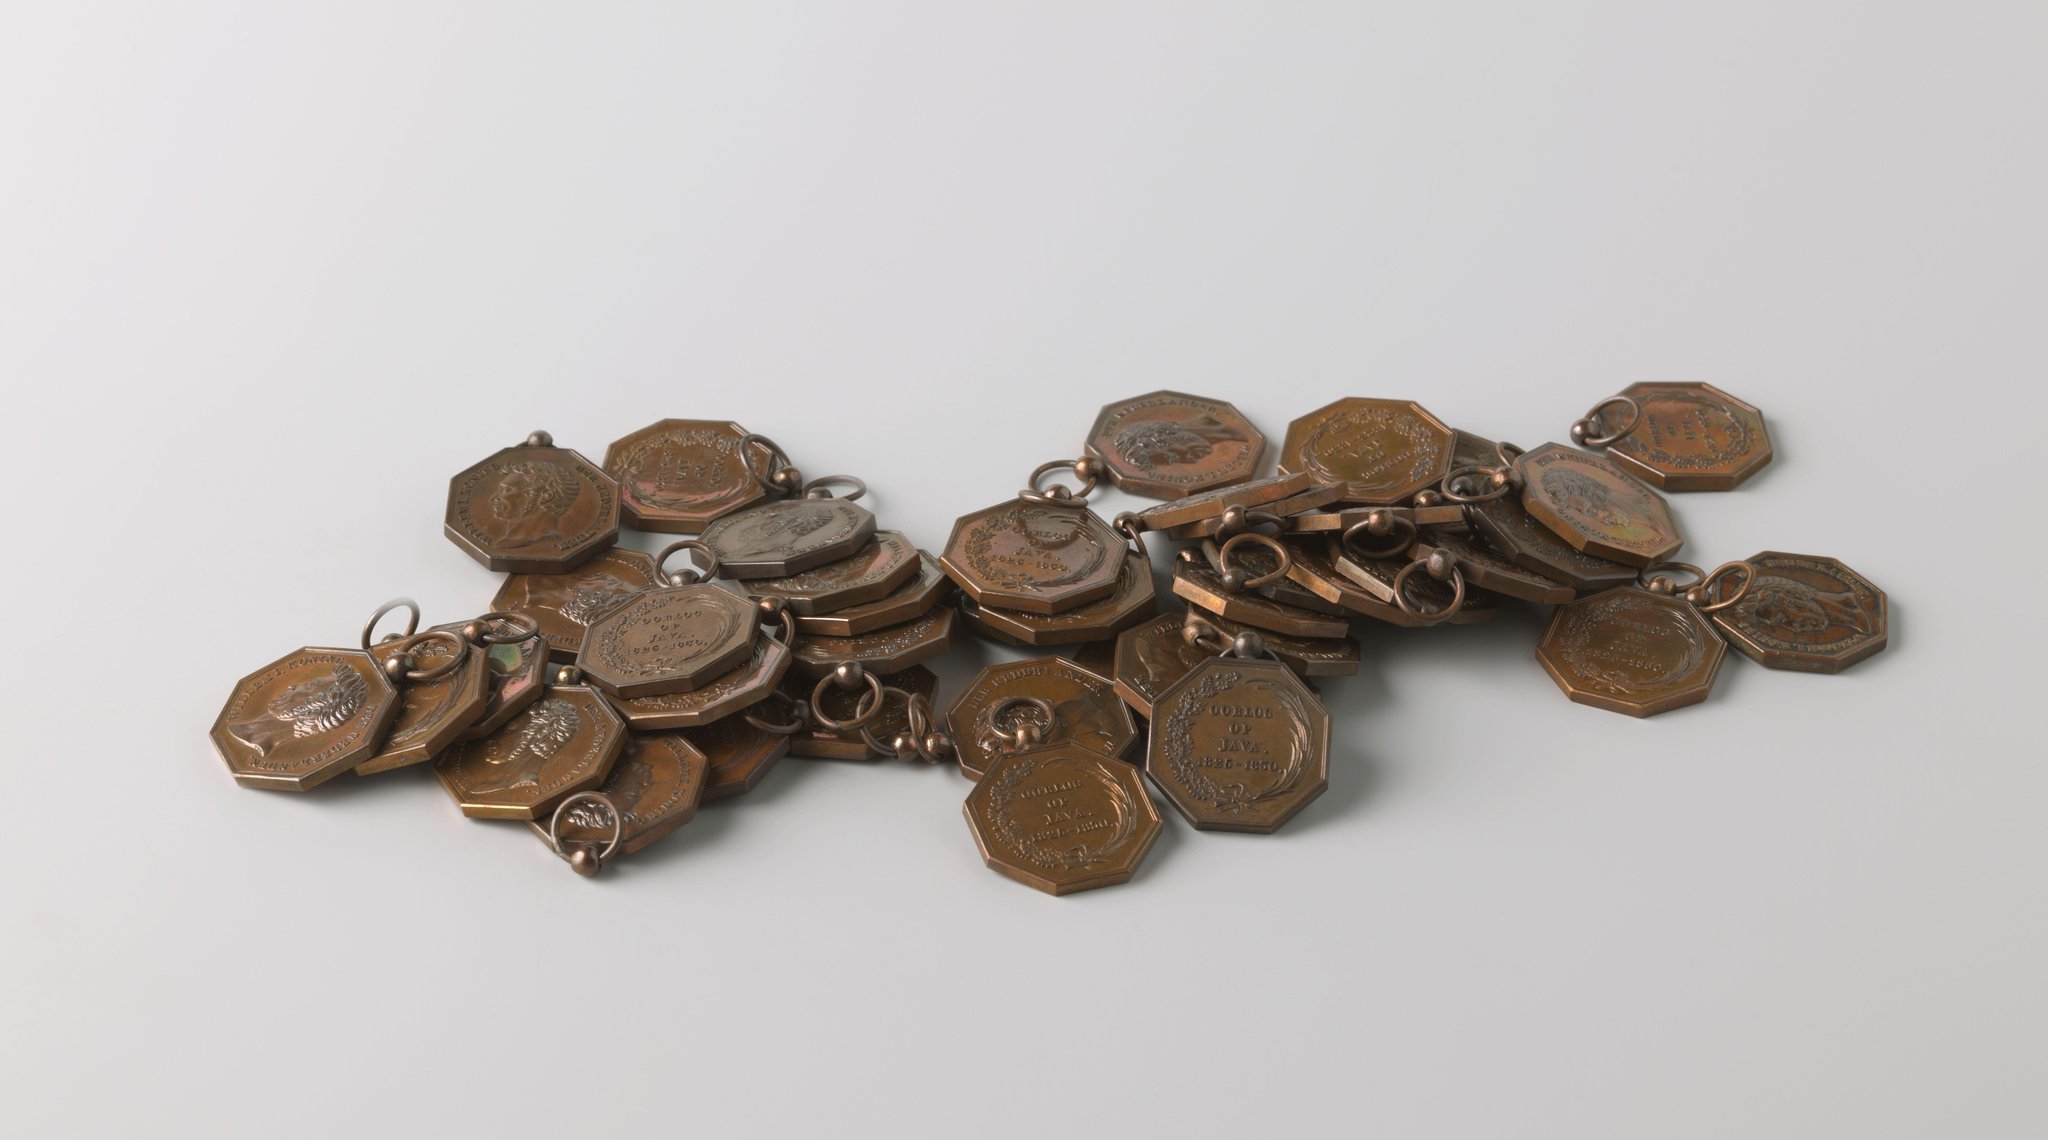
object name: insignia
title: Oorlog op Java, groot draagteken uitgereikt aan de deelnemers, ter ere van Willem I Frederik, koning der Nederlanden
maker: david van der kellen (1804-1879)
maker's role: die cutter, draughtsman, print maker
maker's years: 1804-1879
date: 1830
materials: bronze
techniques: striking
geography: utrecht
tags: the hague, berlin, william i of the netherlands, java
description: Achthoekig draagteken aan draagoog en draagring. Voorzijde: borststuk man binnen omschrift. Keerzijde: opschrift binnen tot krans samengebonden palm- en eiketak; twee aan draaglint.